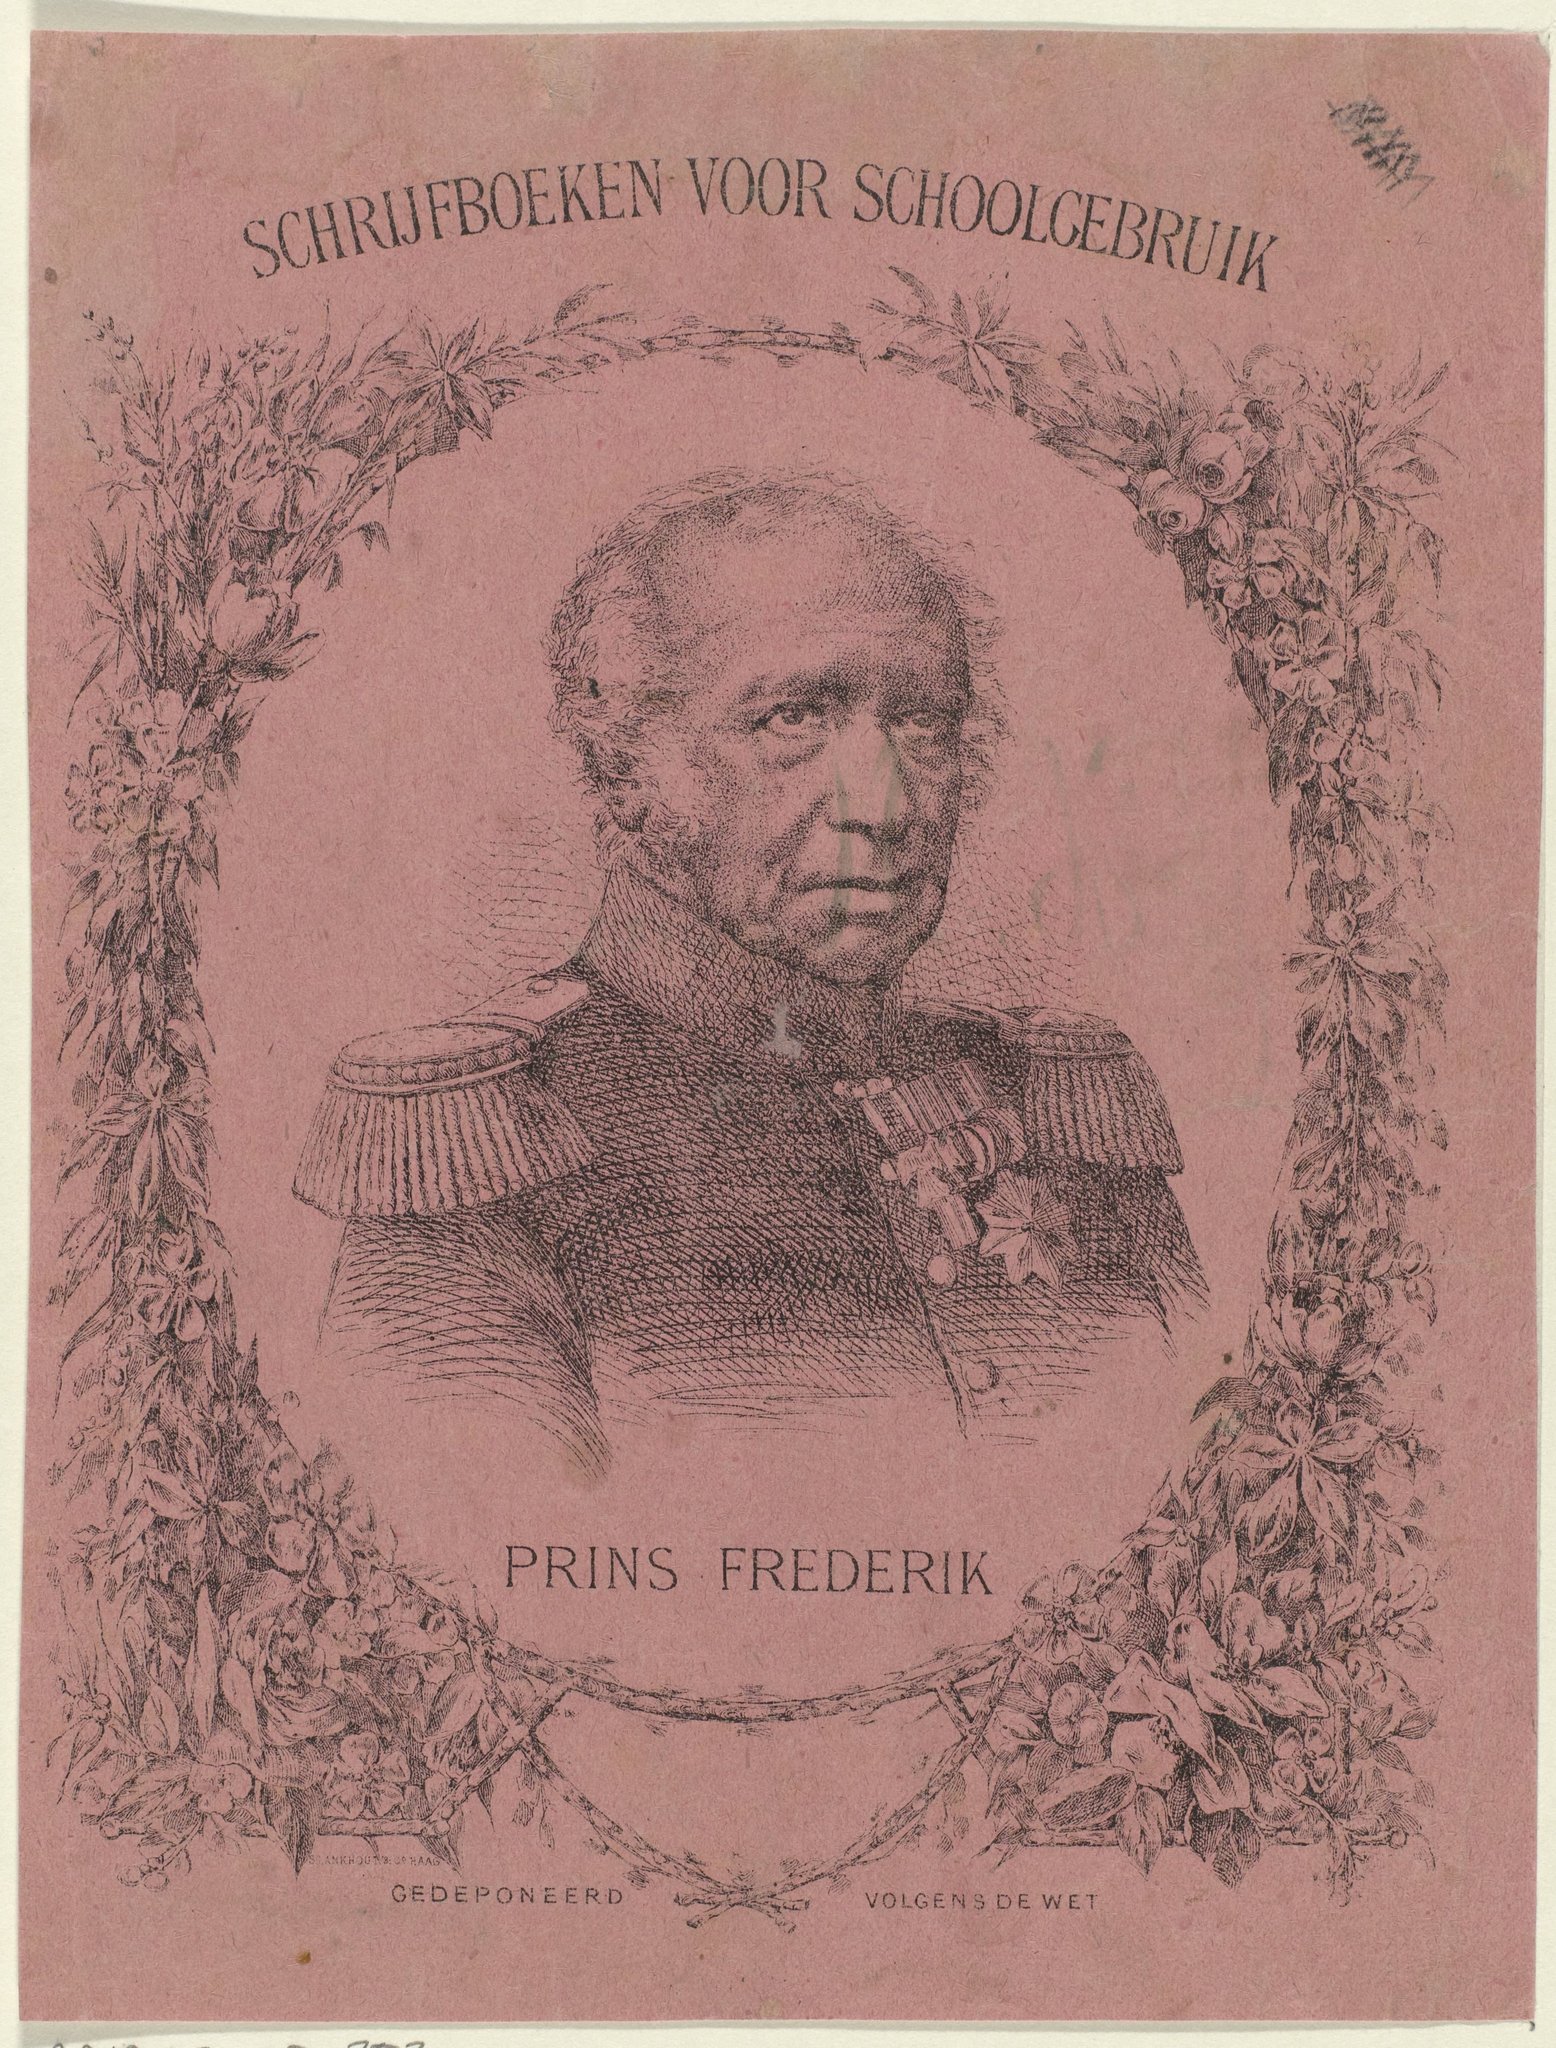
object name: print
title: Portret van Frederik, prins der Nederlanden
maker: Anonymous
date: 1877-1903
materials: paper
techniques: engraving, etching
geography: netherlands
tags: berlin, frederik (prins der nederlanden)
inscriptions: inscription: ‘J.H. Mangert’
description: De hier vermelde titel verwijst naar de hoogst verkregen titel van de geportretteerde, niet per se naar de titel die de geportretteerde op deze voorstelling draagt.